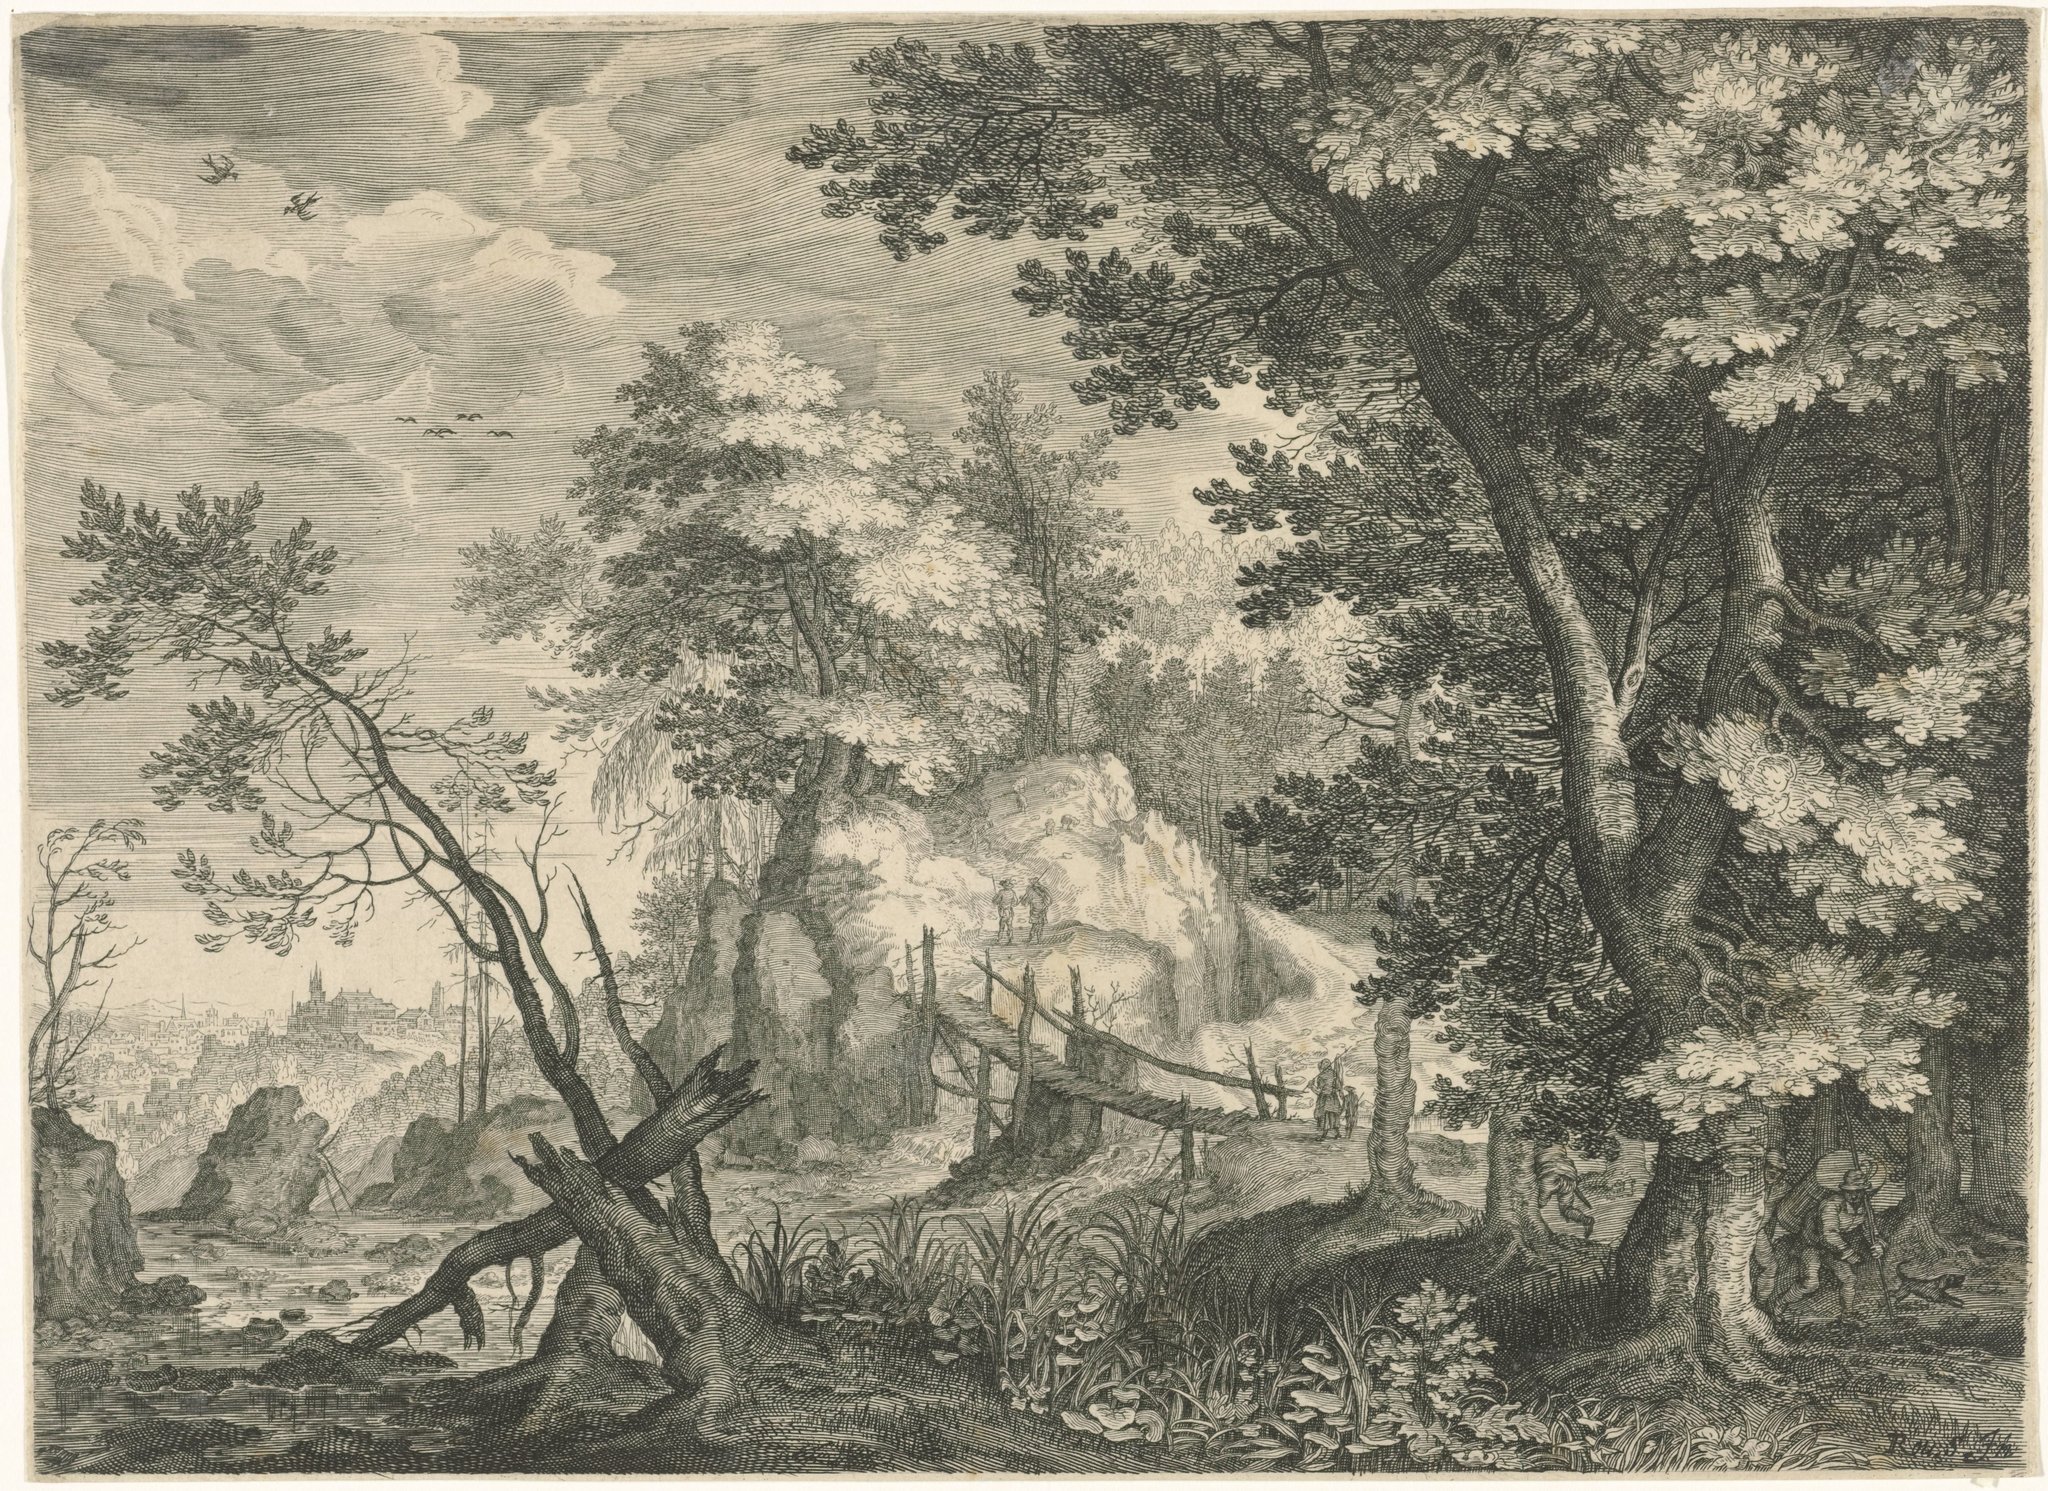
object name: print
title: Boslandschap met houten brug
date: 1609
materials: paper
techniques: engraving, etching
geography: prague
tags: forest, wood, landscape with bridge, viaduct or aqueduct (+ city(-scape) with figures, staffage)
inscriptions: collector's mark: Lugt 240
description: Boslandschap met houten brug en enkele reizigers. Stad in de verte. Zesde prent van een zesdelige reeks met berglandschappen uit Tirol.